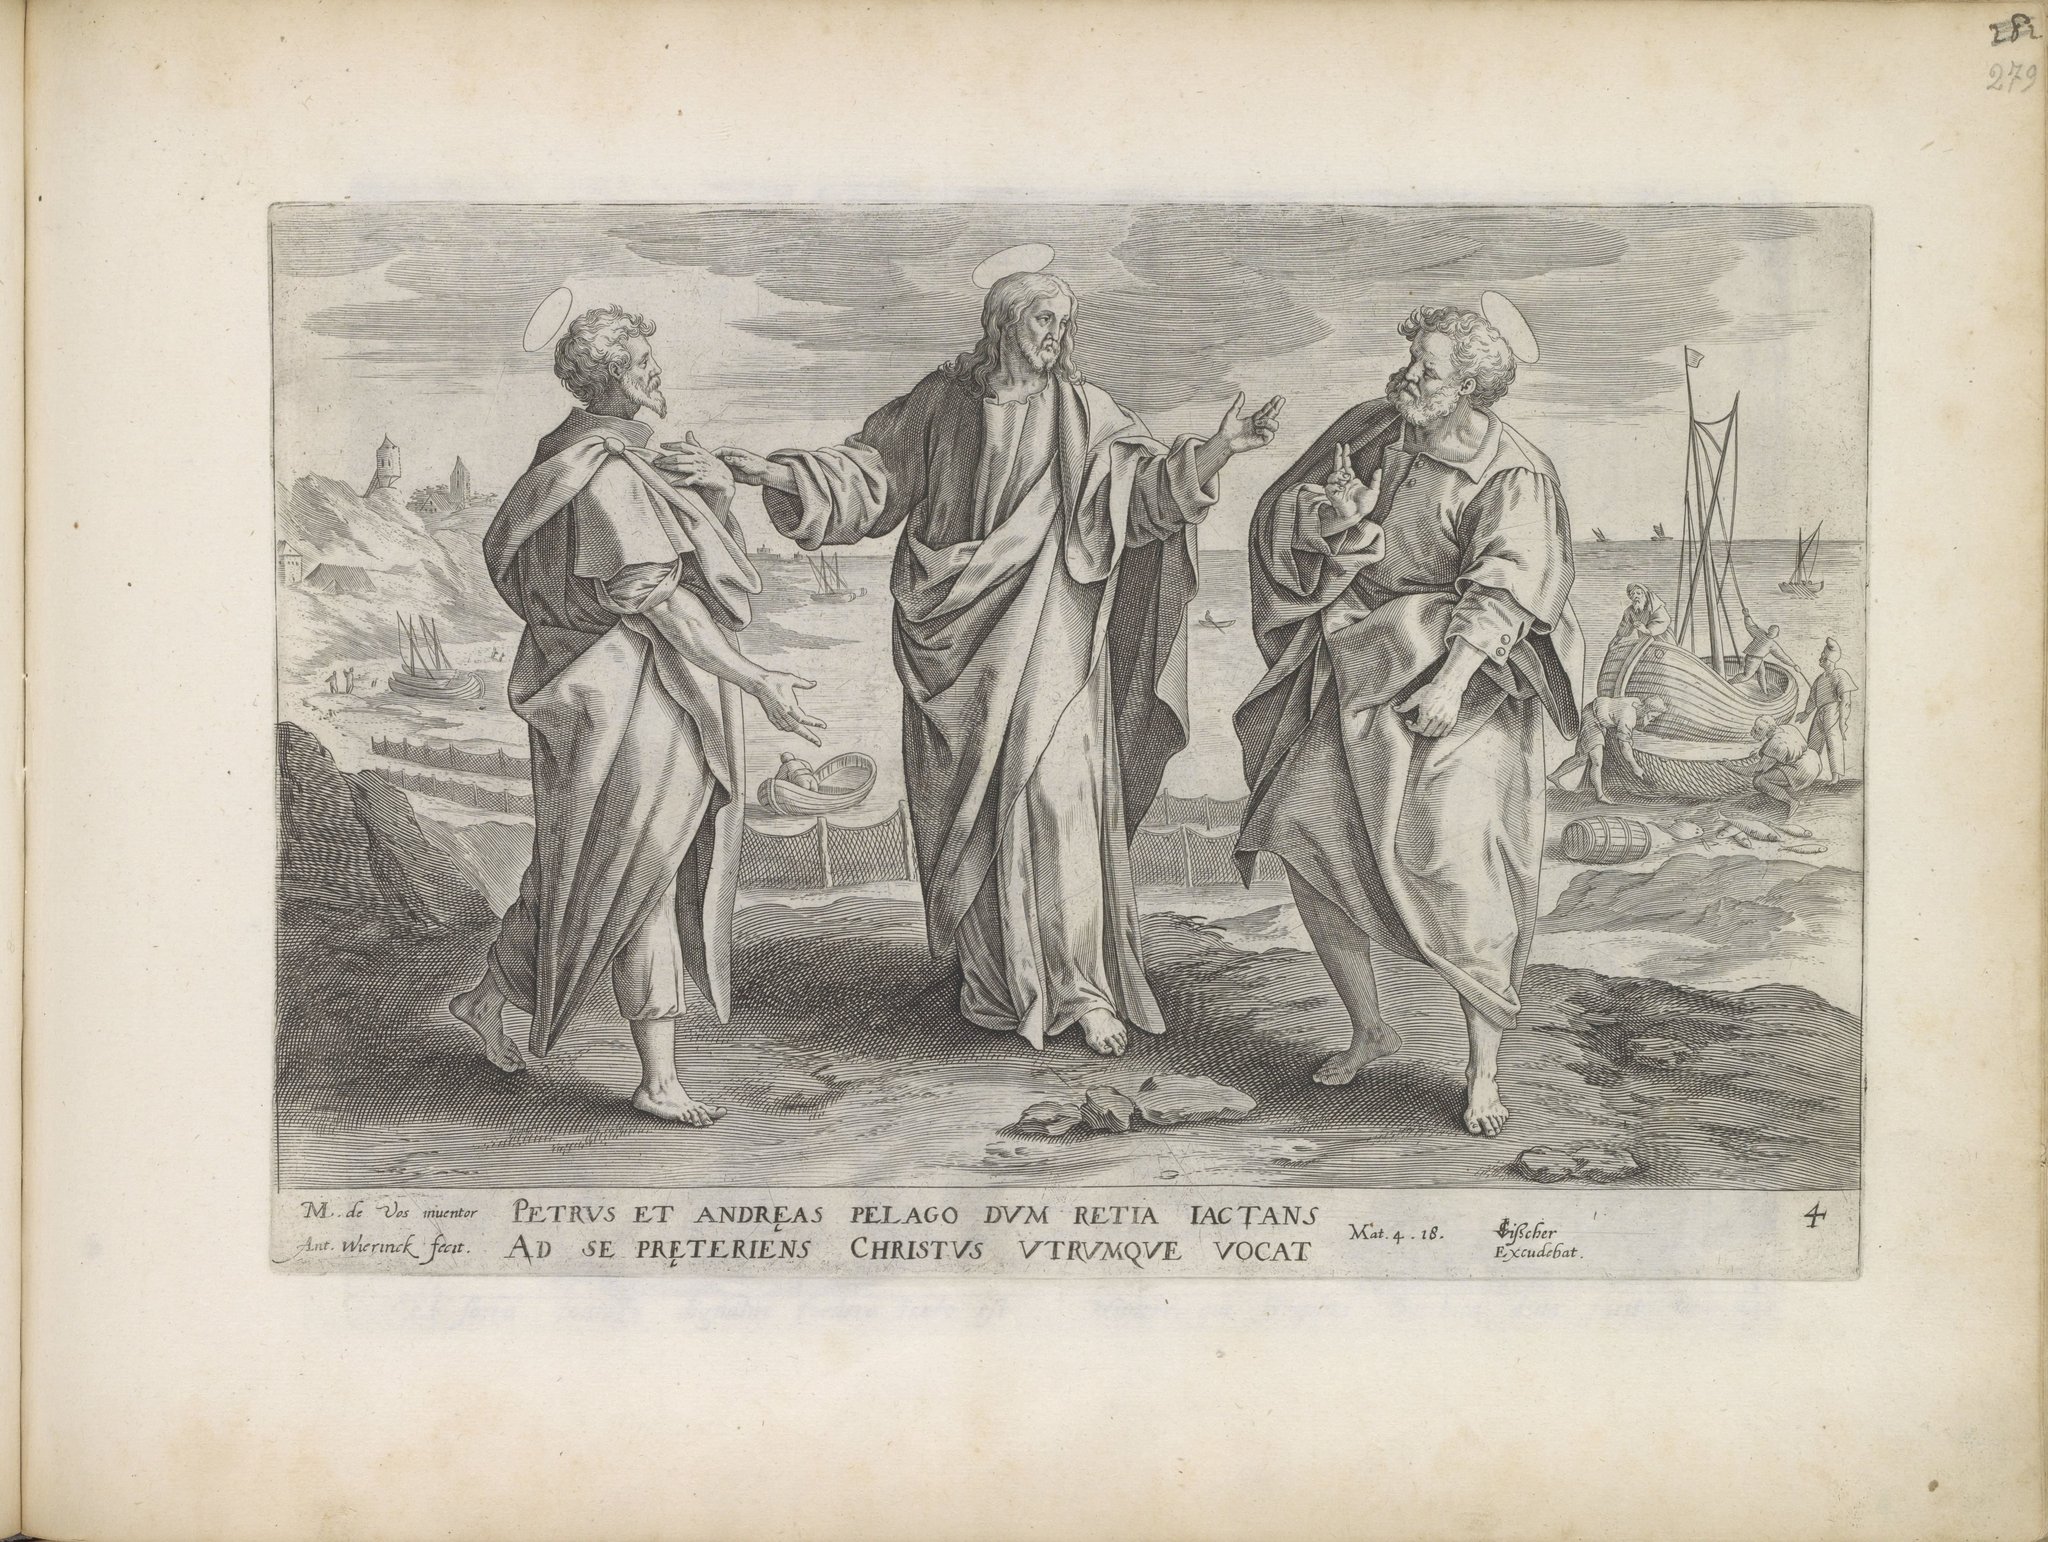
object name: album leaf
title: Theatrum Biblicum Hoc Est Historiae Sacrae Veteris et Novi Testamenti Tabulis Aeneis Expressae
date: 1585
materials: paper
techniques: engraving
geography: amsterdam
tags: calling of peter and andrew (john 1:40-42)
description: Christus roept Andreas en Petrus op om hem te volgen en hun vissersnetten achter te laten. Rechts op de achtergrond wat voorafging: Andreas en Petrus gooien hun netten uit in het meer. Onder de voorstelling een verwijzing in het Latijn naar de Bijbeltekst in Mat. 4:18. Deze prent maakt deel uit van een album.